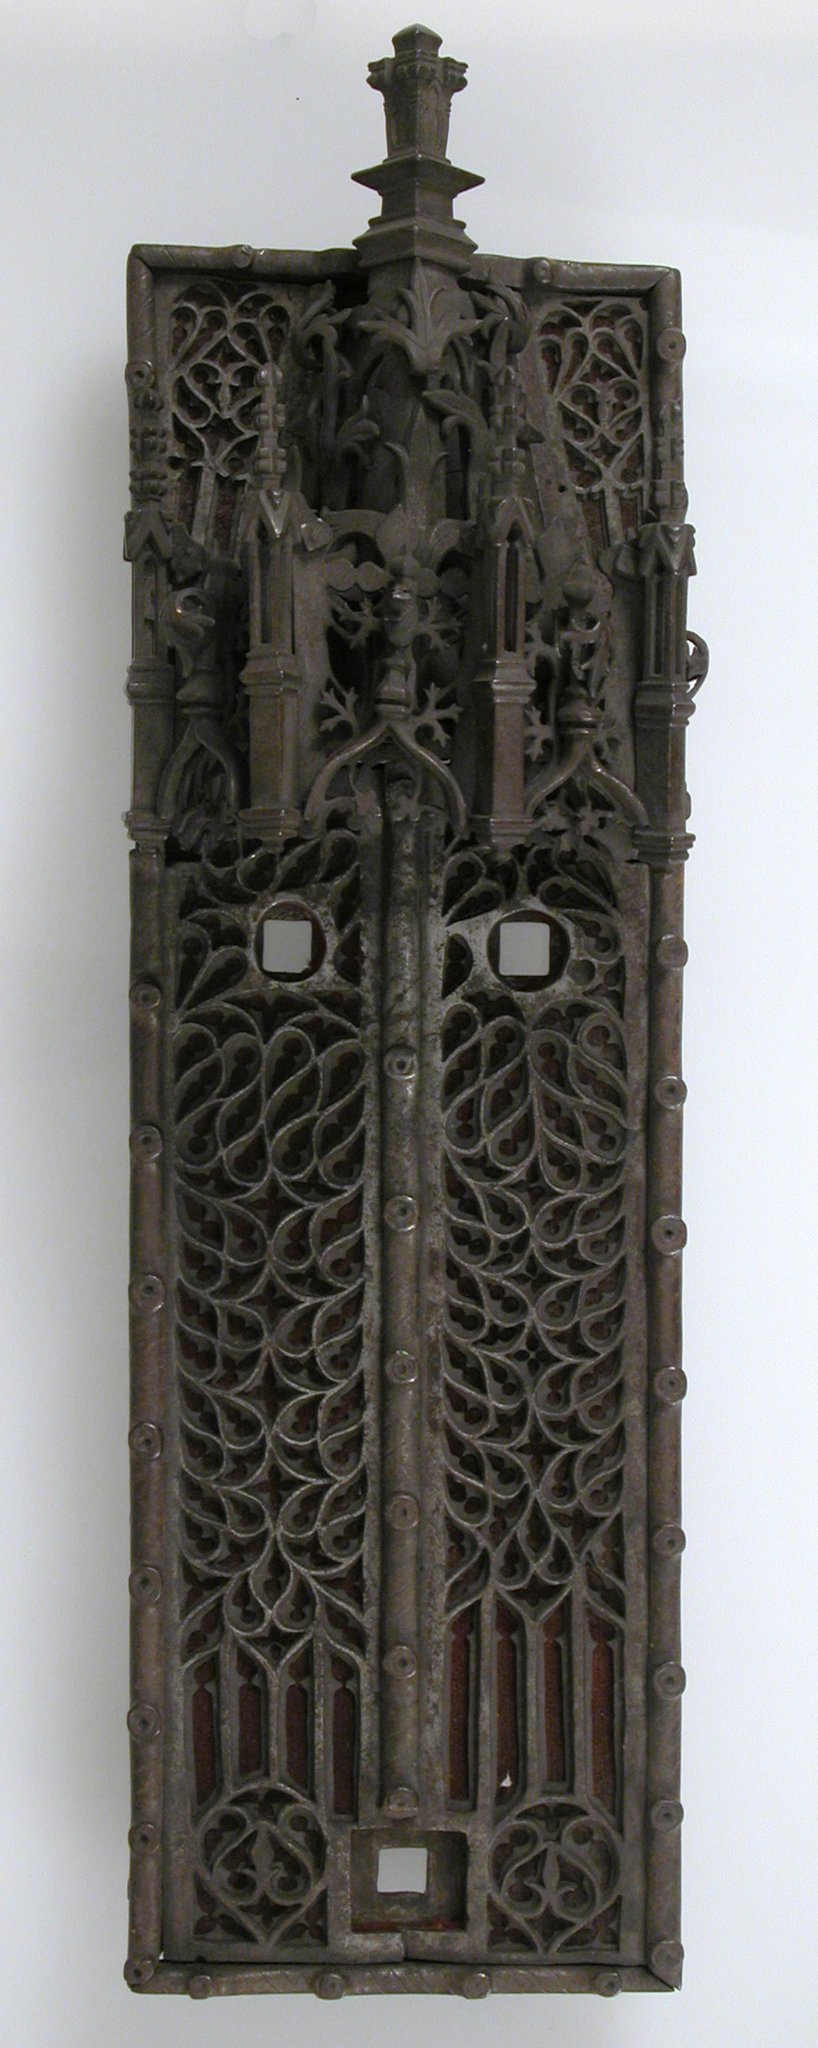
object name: door knocker plate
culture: french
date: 1401-1500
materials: iron, textile